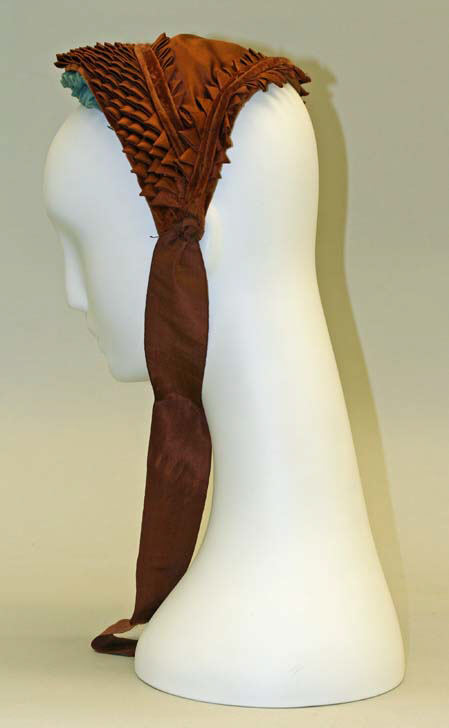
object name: bonnet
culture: american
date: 1865-1868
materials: silk, metal